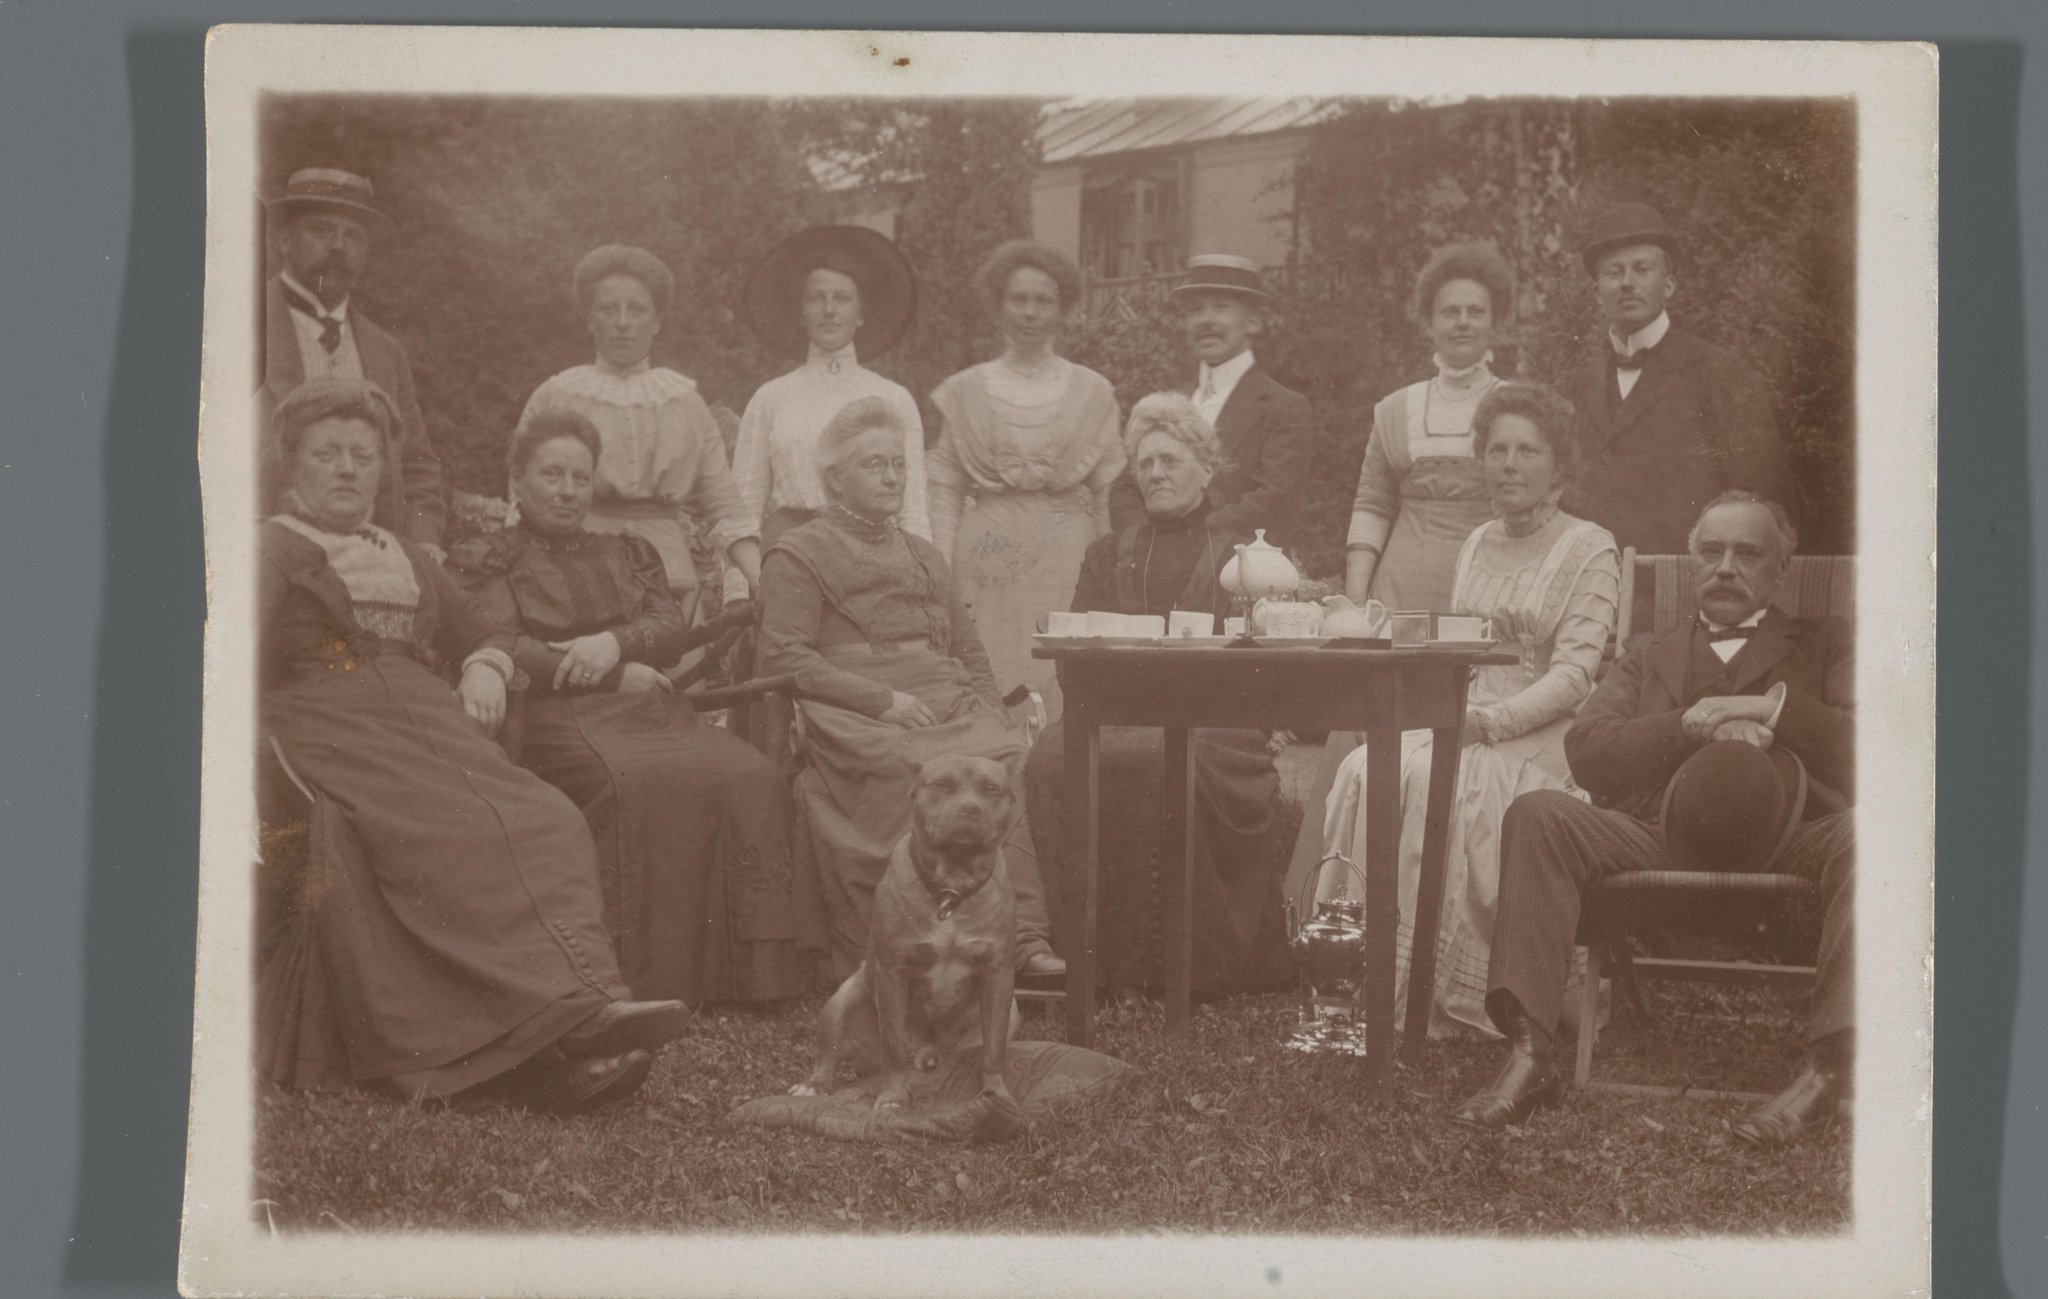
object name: photograph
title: Familieportret in een tuin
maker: Anonymous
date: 1880-1940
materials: photographic support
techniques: collodion silver print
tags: anonymous historical persons portrayed in a group, in a group-portrait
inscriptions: annotation: ‘Nunspeet’, number: ‘2429’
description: Op verso staan lijnen voor adres en postzegel gedrukt.